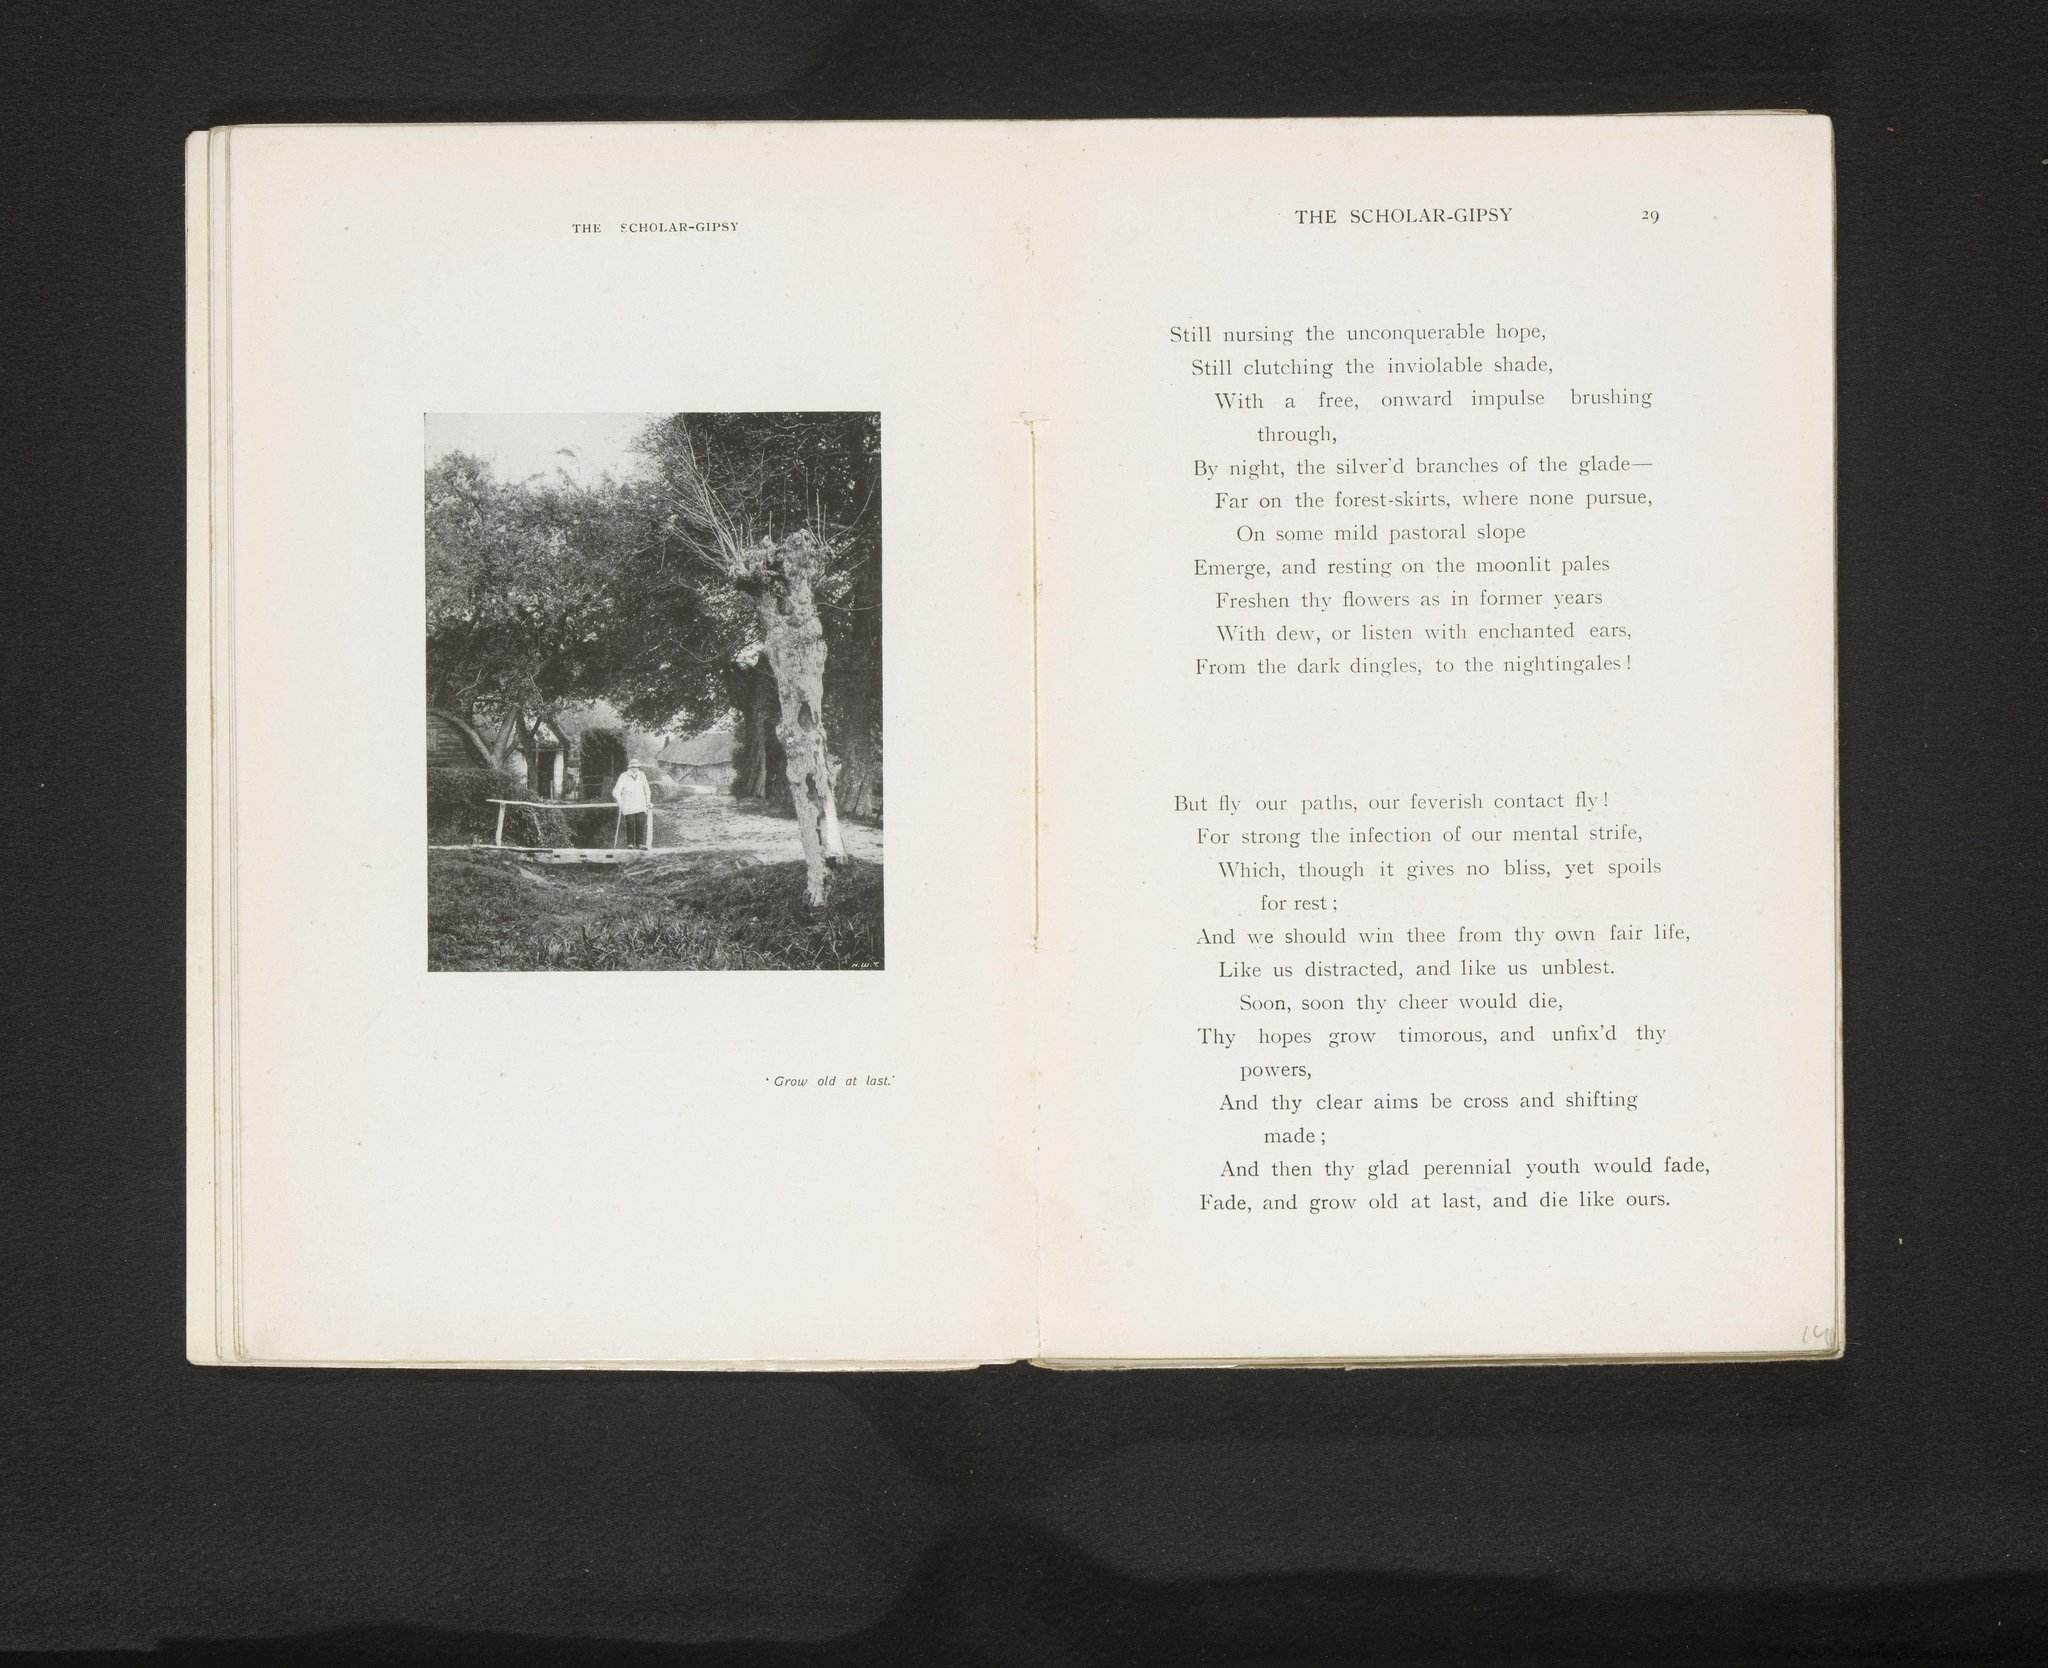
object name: photomechanical print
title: Oude man op een brug in een dorp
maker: henry w. taunt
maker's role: fotograaf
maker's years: 1842-1922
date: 1907-1912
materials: paper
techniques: autotype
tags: old man, bridge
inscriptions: inscription: ‘'Grow old at last.'’